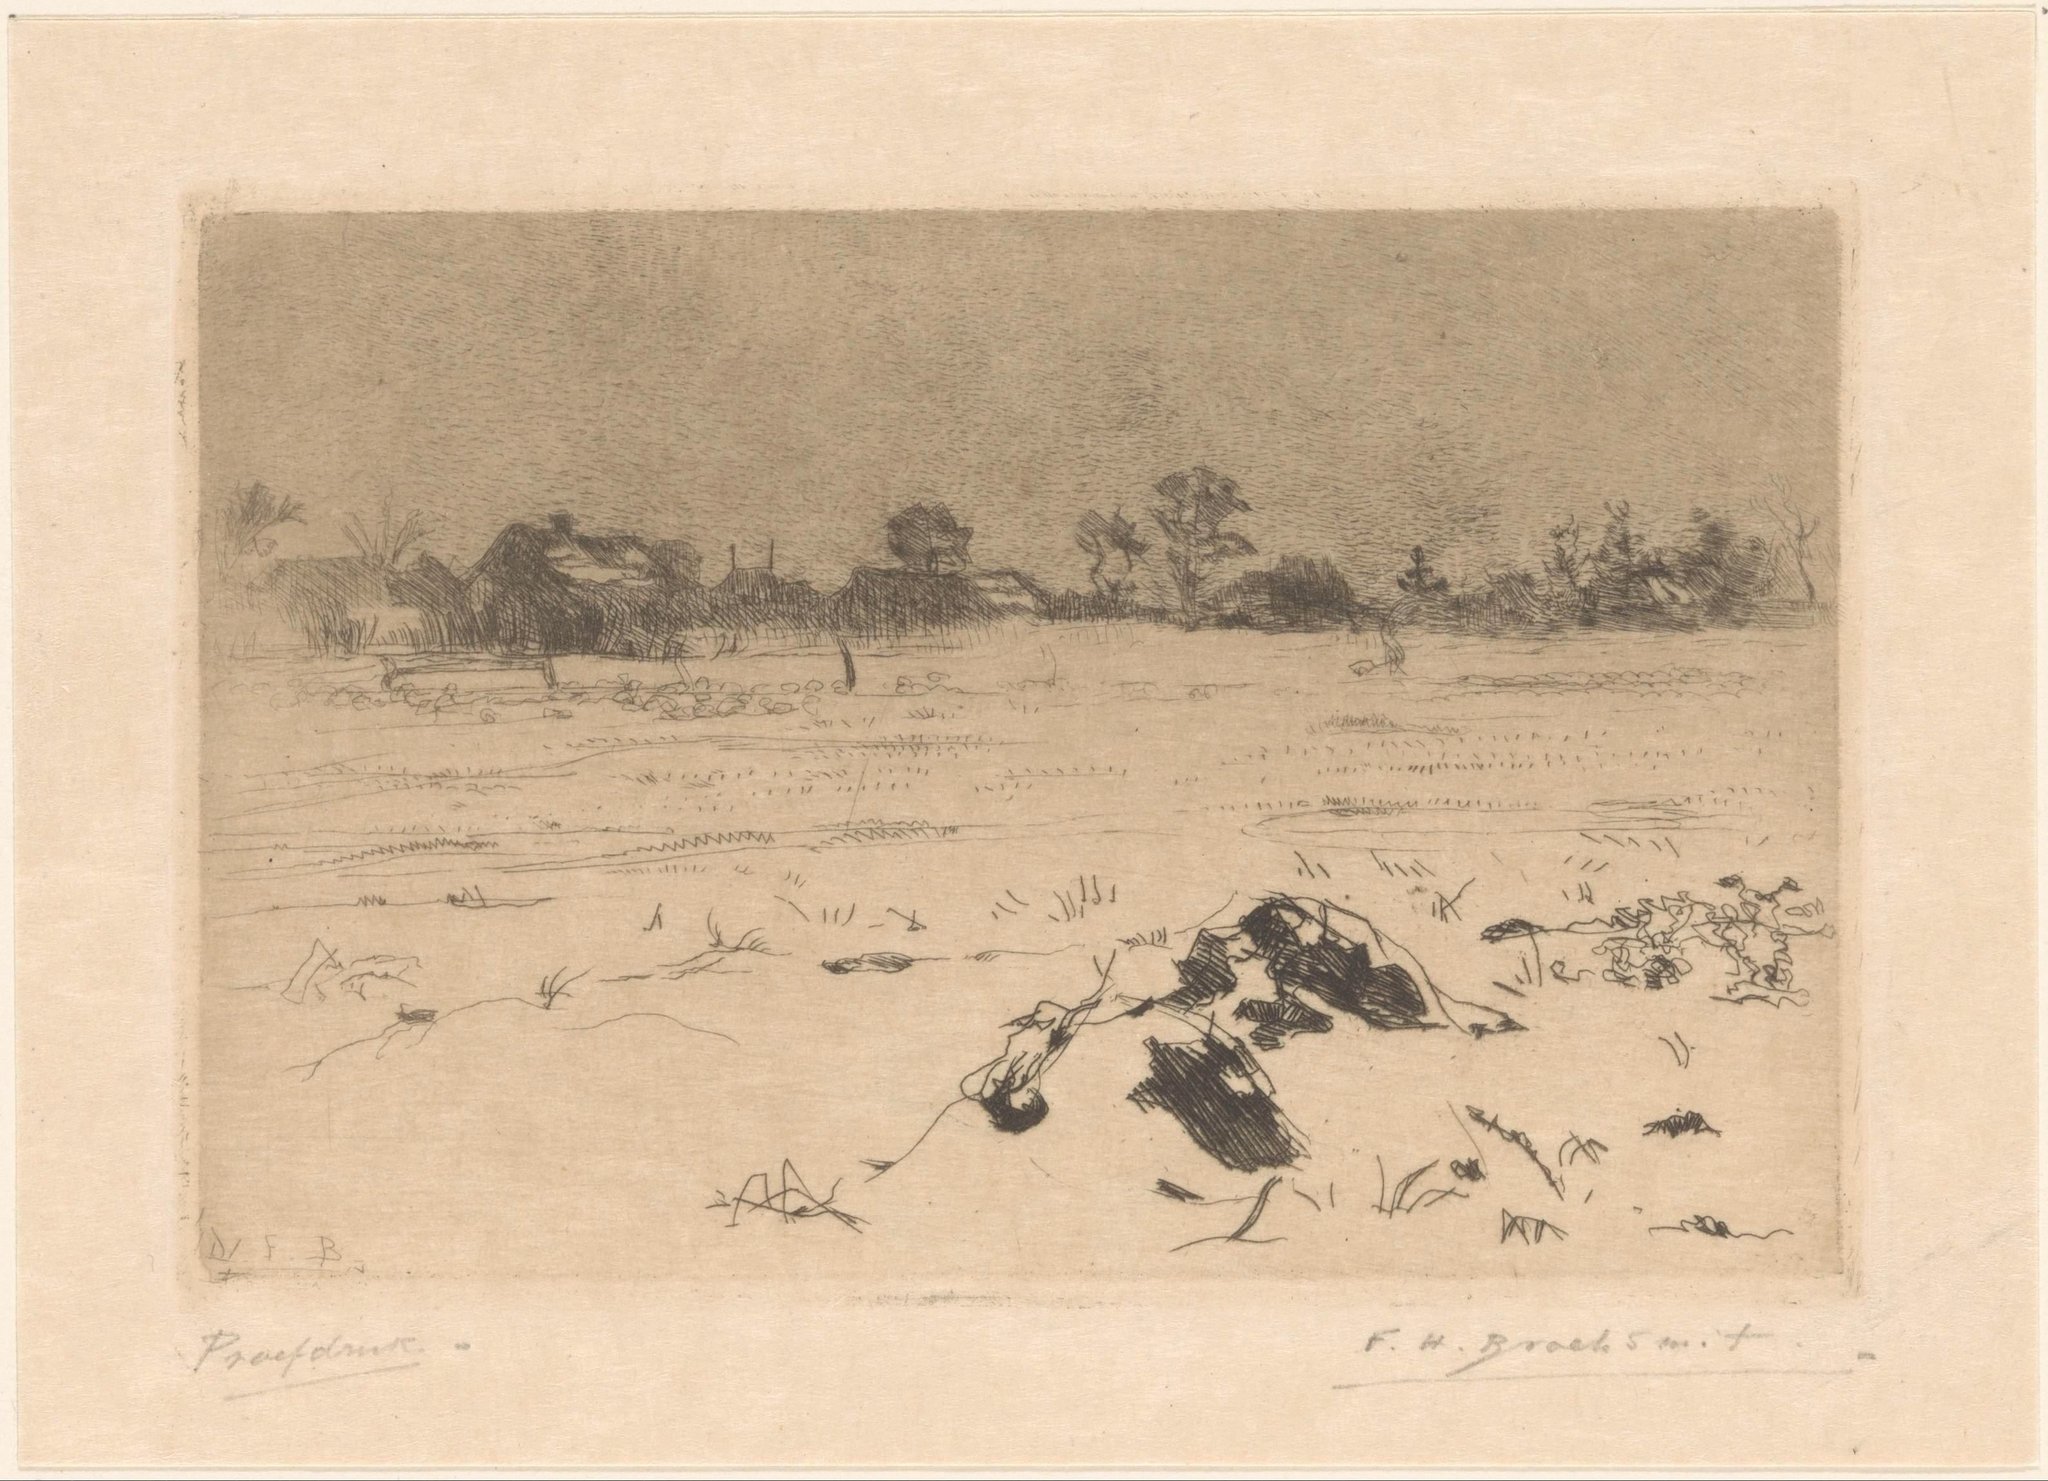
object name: print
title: Sneeuw in Elspeet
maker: frederika henriëtte broeksmit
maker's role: draughtsman, print maker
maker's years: 1875-1945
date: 1885-1931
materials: paper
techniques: etching, intaglio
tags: prospect of village, silhouette of village, snow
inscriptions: collector's mark: Lugt 2228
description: Besneeuwde weilanden. Op de achtergrond huizen en bomen.